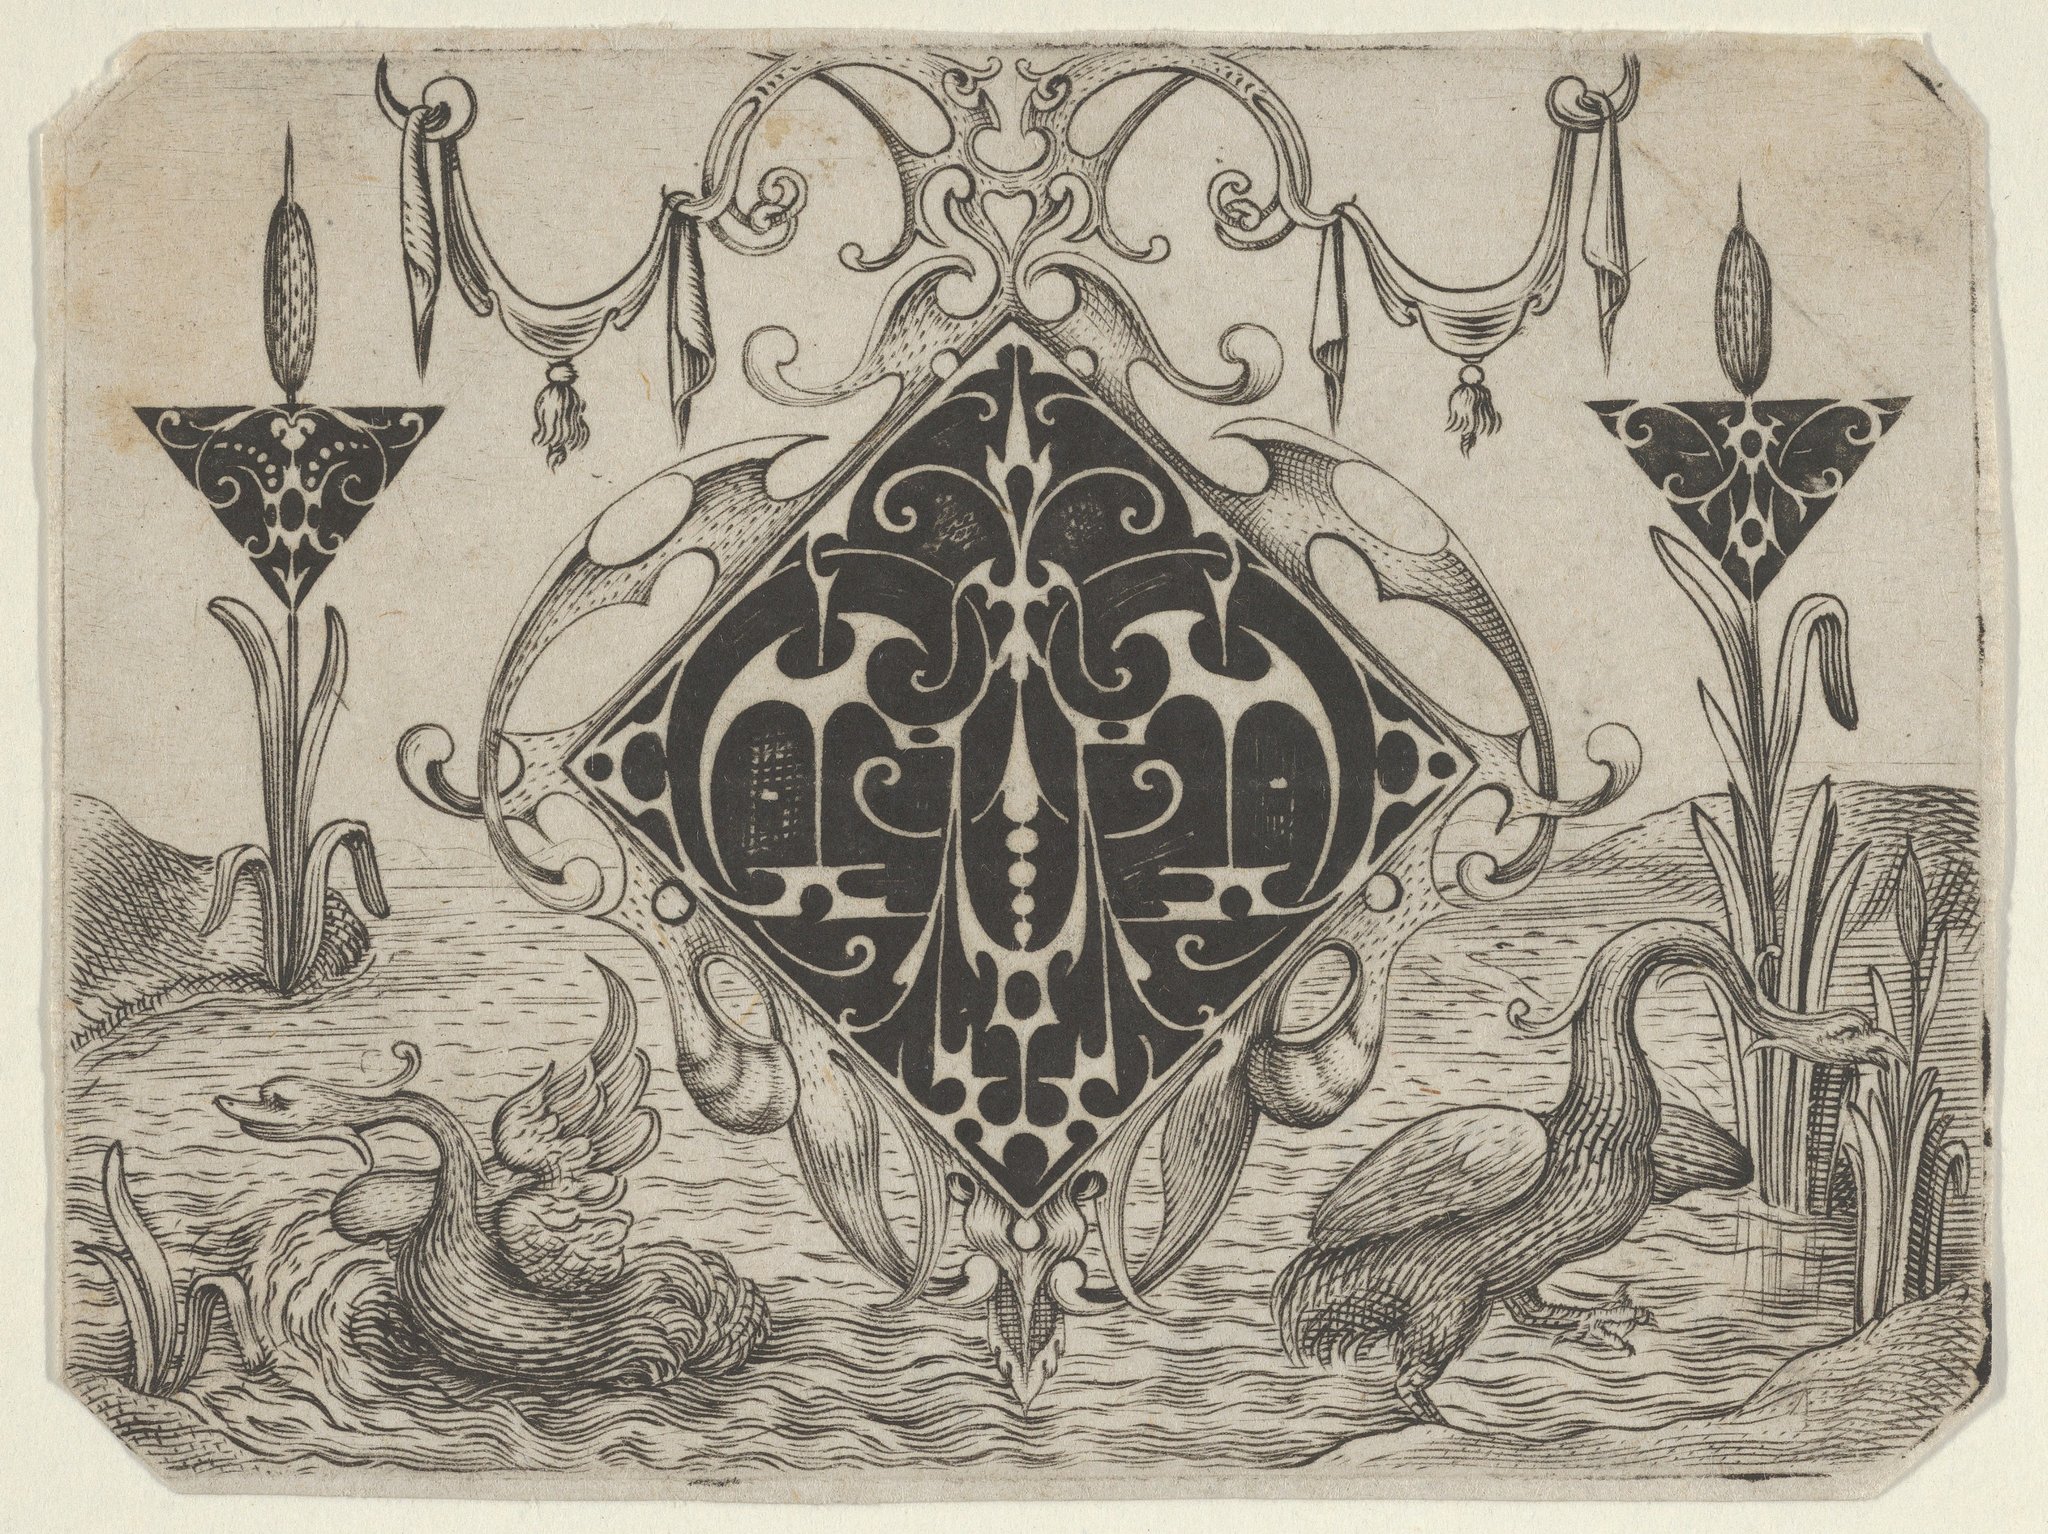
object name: print collection ornament architecture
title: Lozenge-shaped Pendant and Two Triangular Motifs in a Riverscape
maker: giovanni battista costantini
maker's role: printmaker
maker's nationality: italian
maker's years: 1615-1628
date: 1622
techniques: embroidery, engraving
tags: birds,pendants